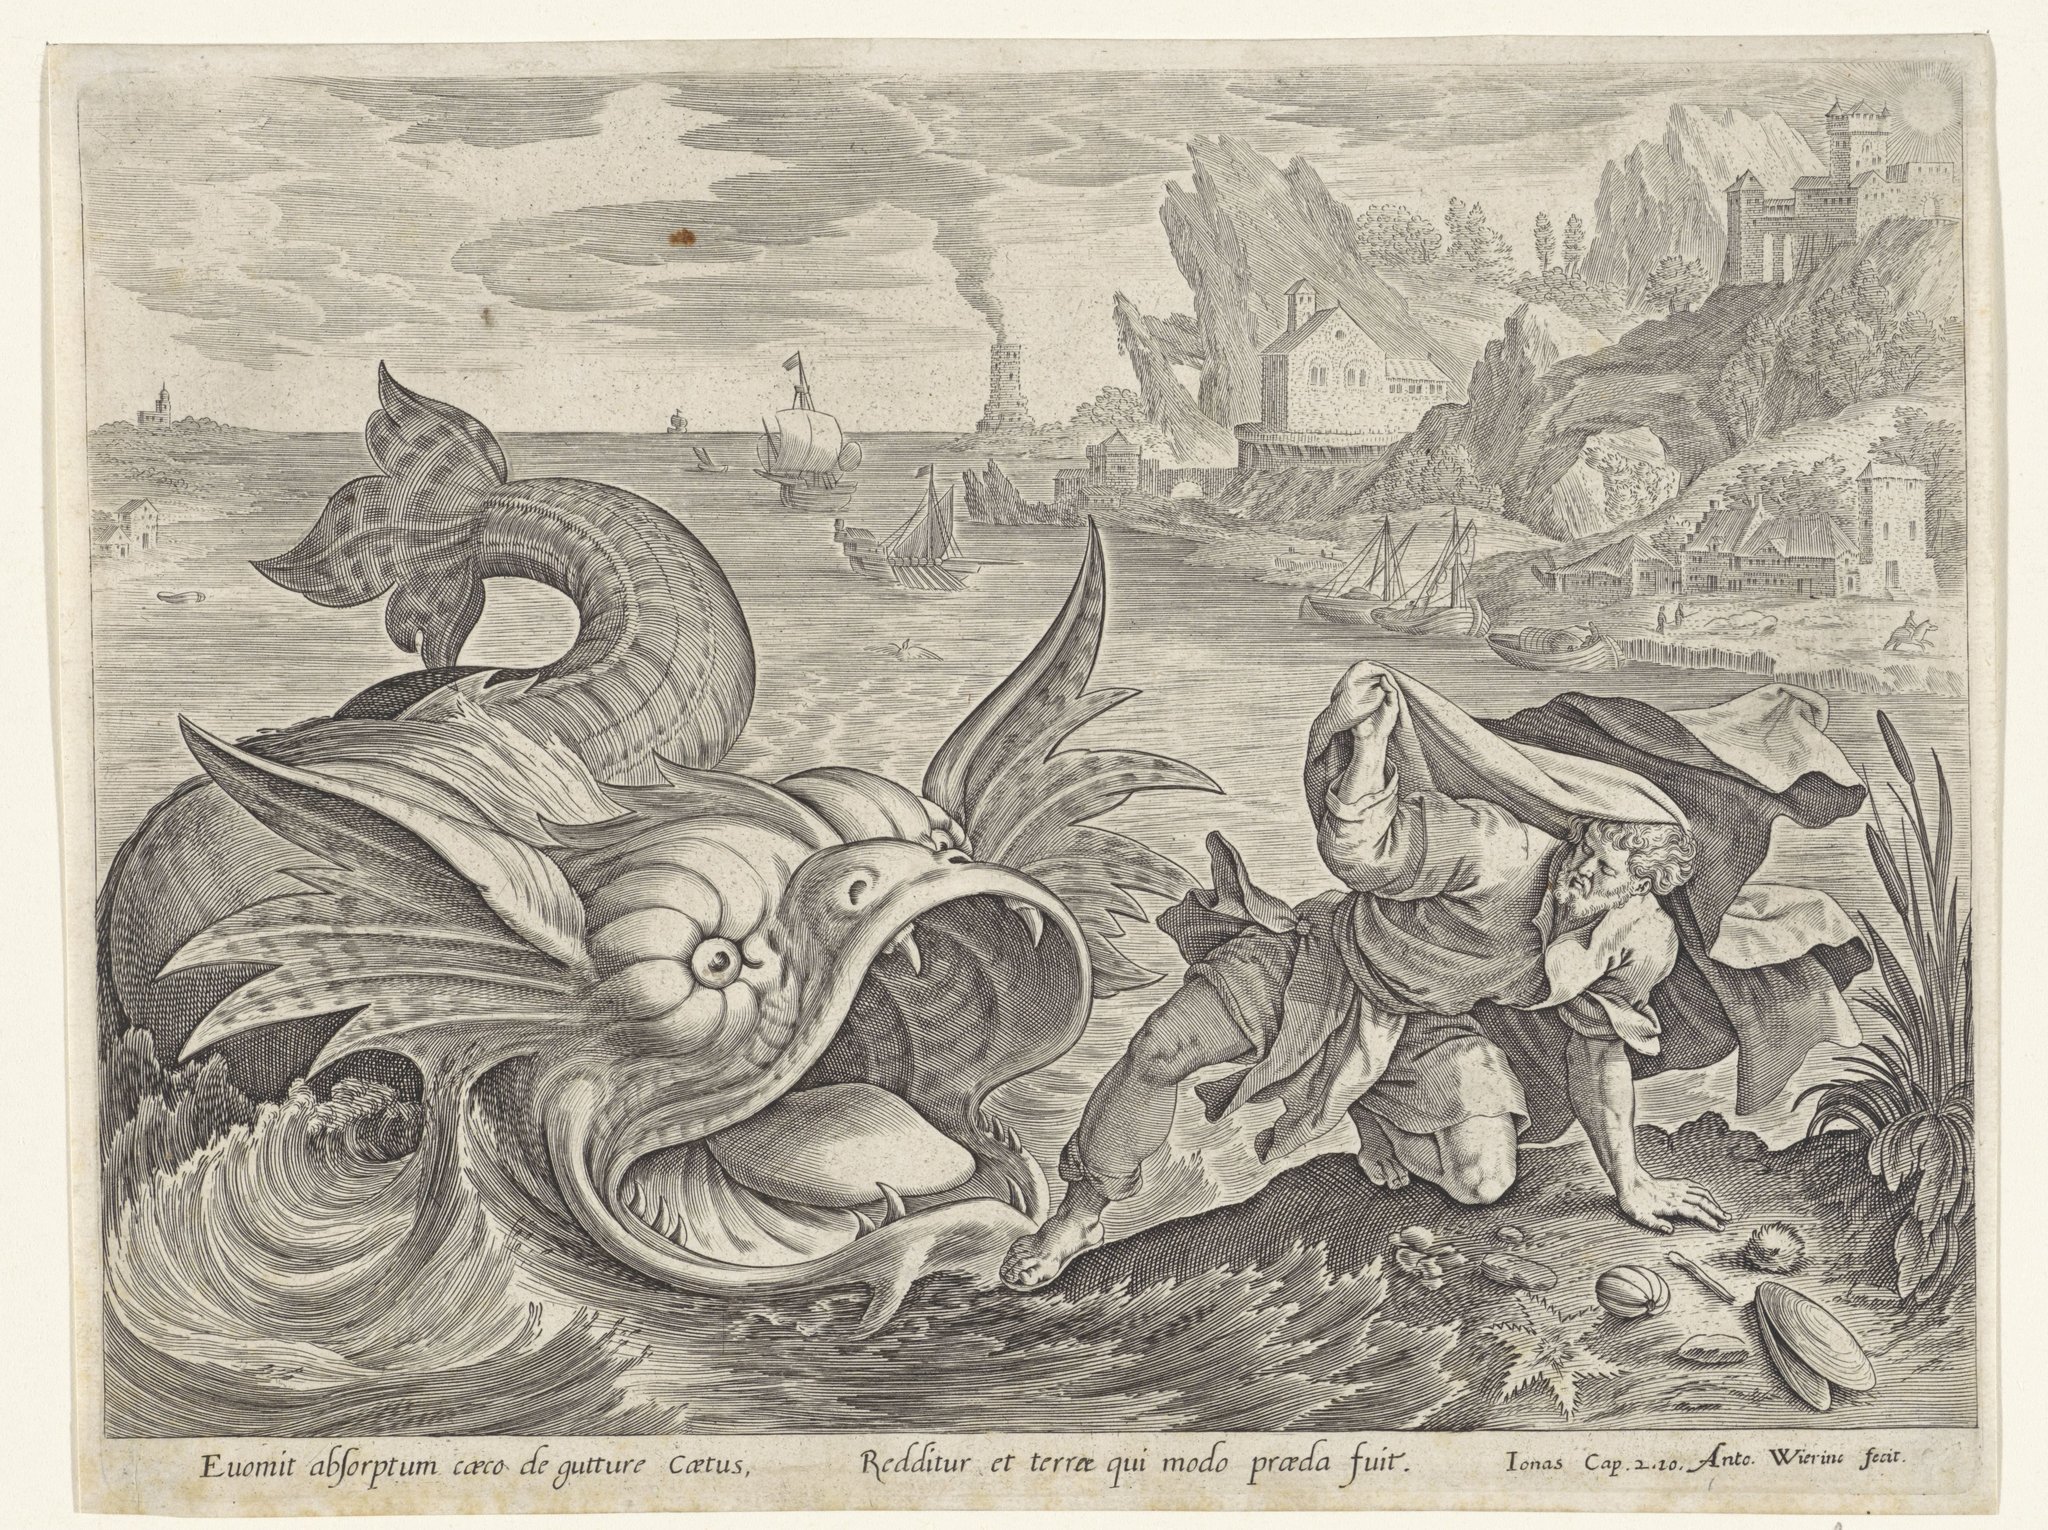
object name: print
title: Geschiedenis van Jona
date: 1585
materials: paper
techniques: engraving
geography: antwerp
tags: after a three-day sojourn in the belly of the monster jonah is cast on dry land; jonah may be shown nude and bald-headed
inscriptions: collector's mark: Lugt 2228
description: Prent gebruikt in: Thesaurus sacrarum historiaru[m] veteris (et novi) testame[n]ti, elega[n]tissimis imaginibus expressu[m] excelle[n]tissimoru[m] in hac arte viroru[m] opera : nu[n]c primu[m] in luce[m] editus. Antwerpen: Gerard de Jode, 1585.